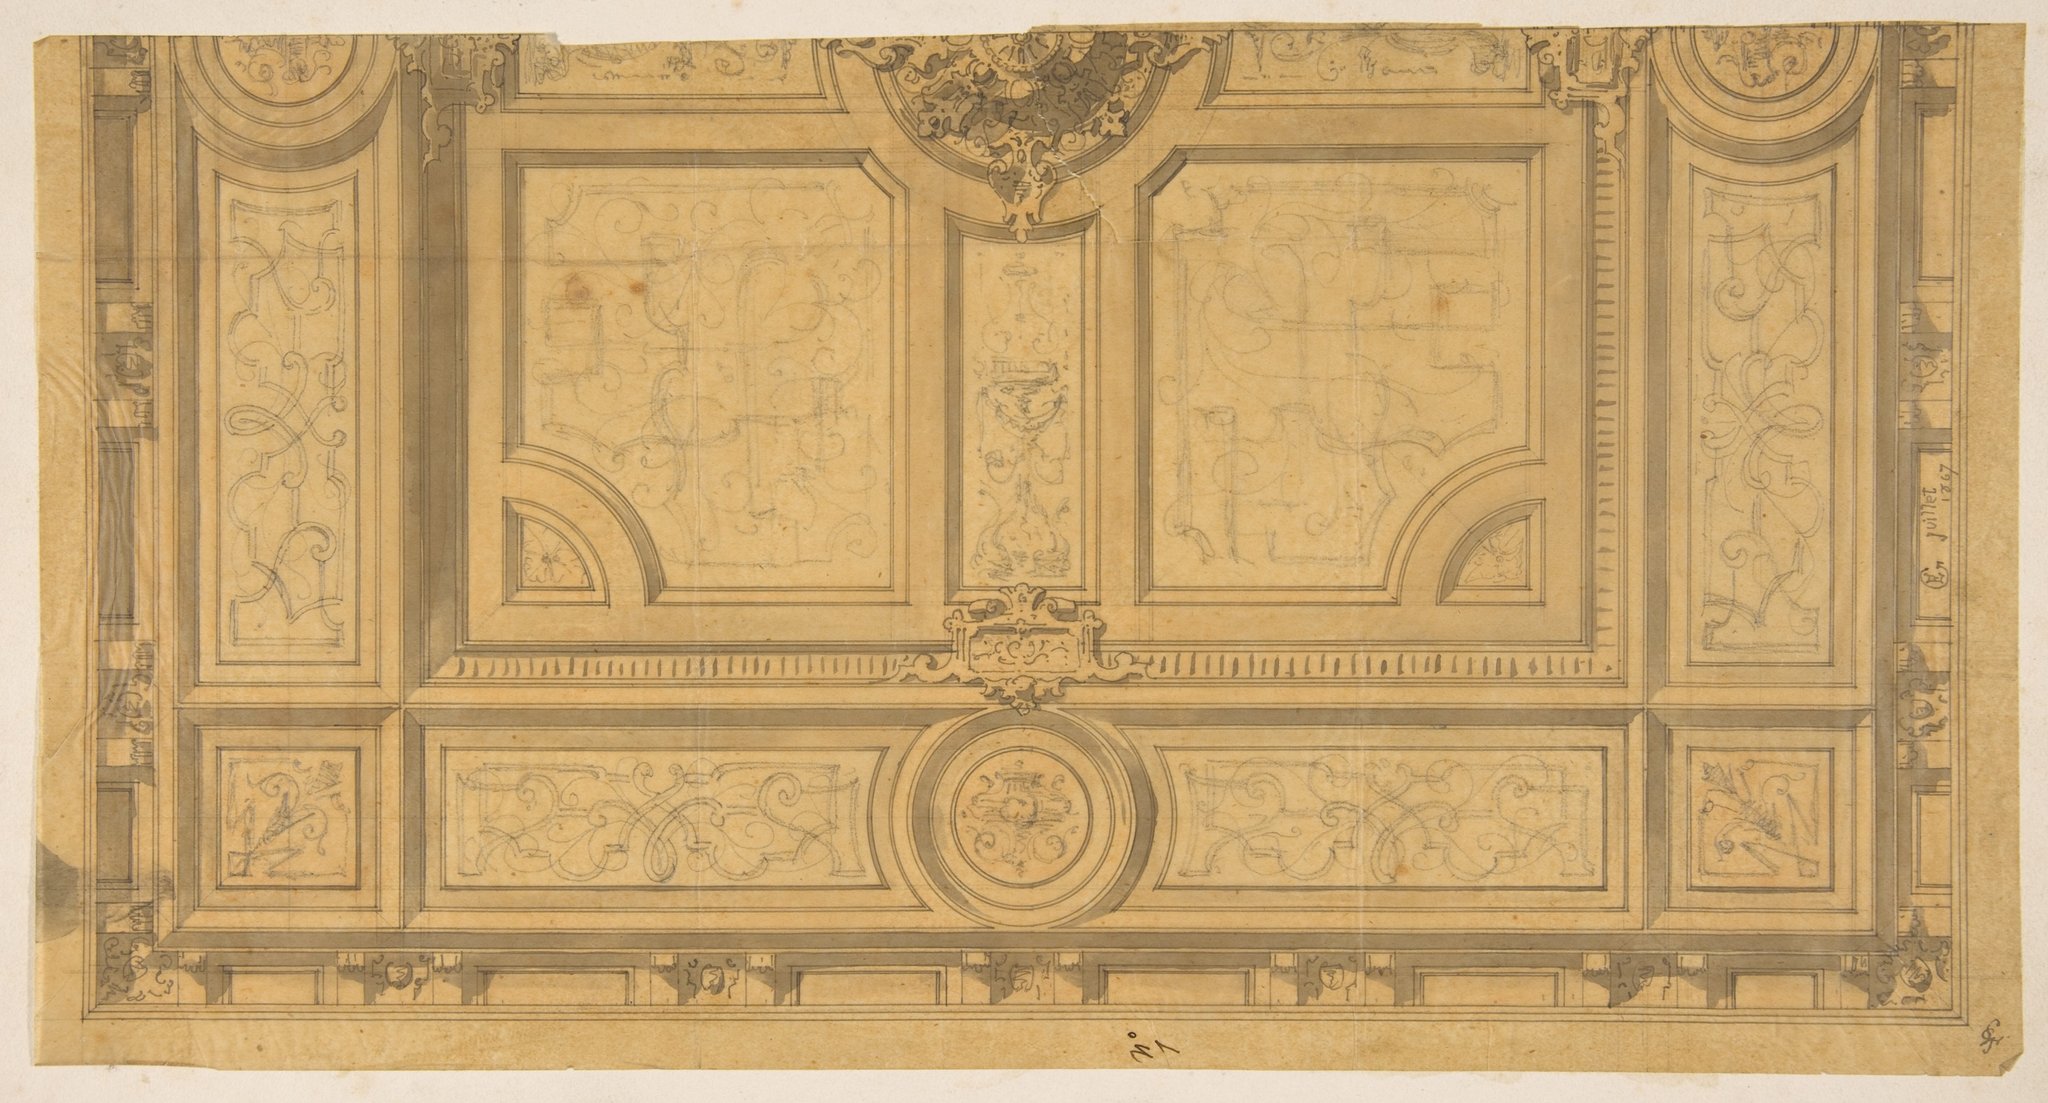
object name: drawing ornament architecture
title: Design for Half of a Ceiling Decoration, Fontainbleau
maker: jules-edmond-charles lachaise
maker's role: artist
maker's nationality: french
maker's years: 1897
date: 1867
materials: graphite, ink, paper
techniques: pen, transfer, wash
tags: ceilings